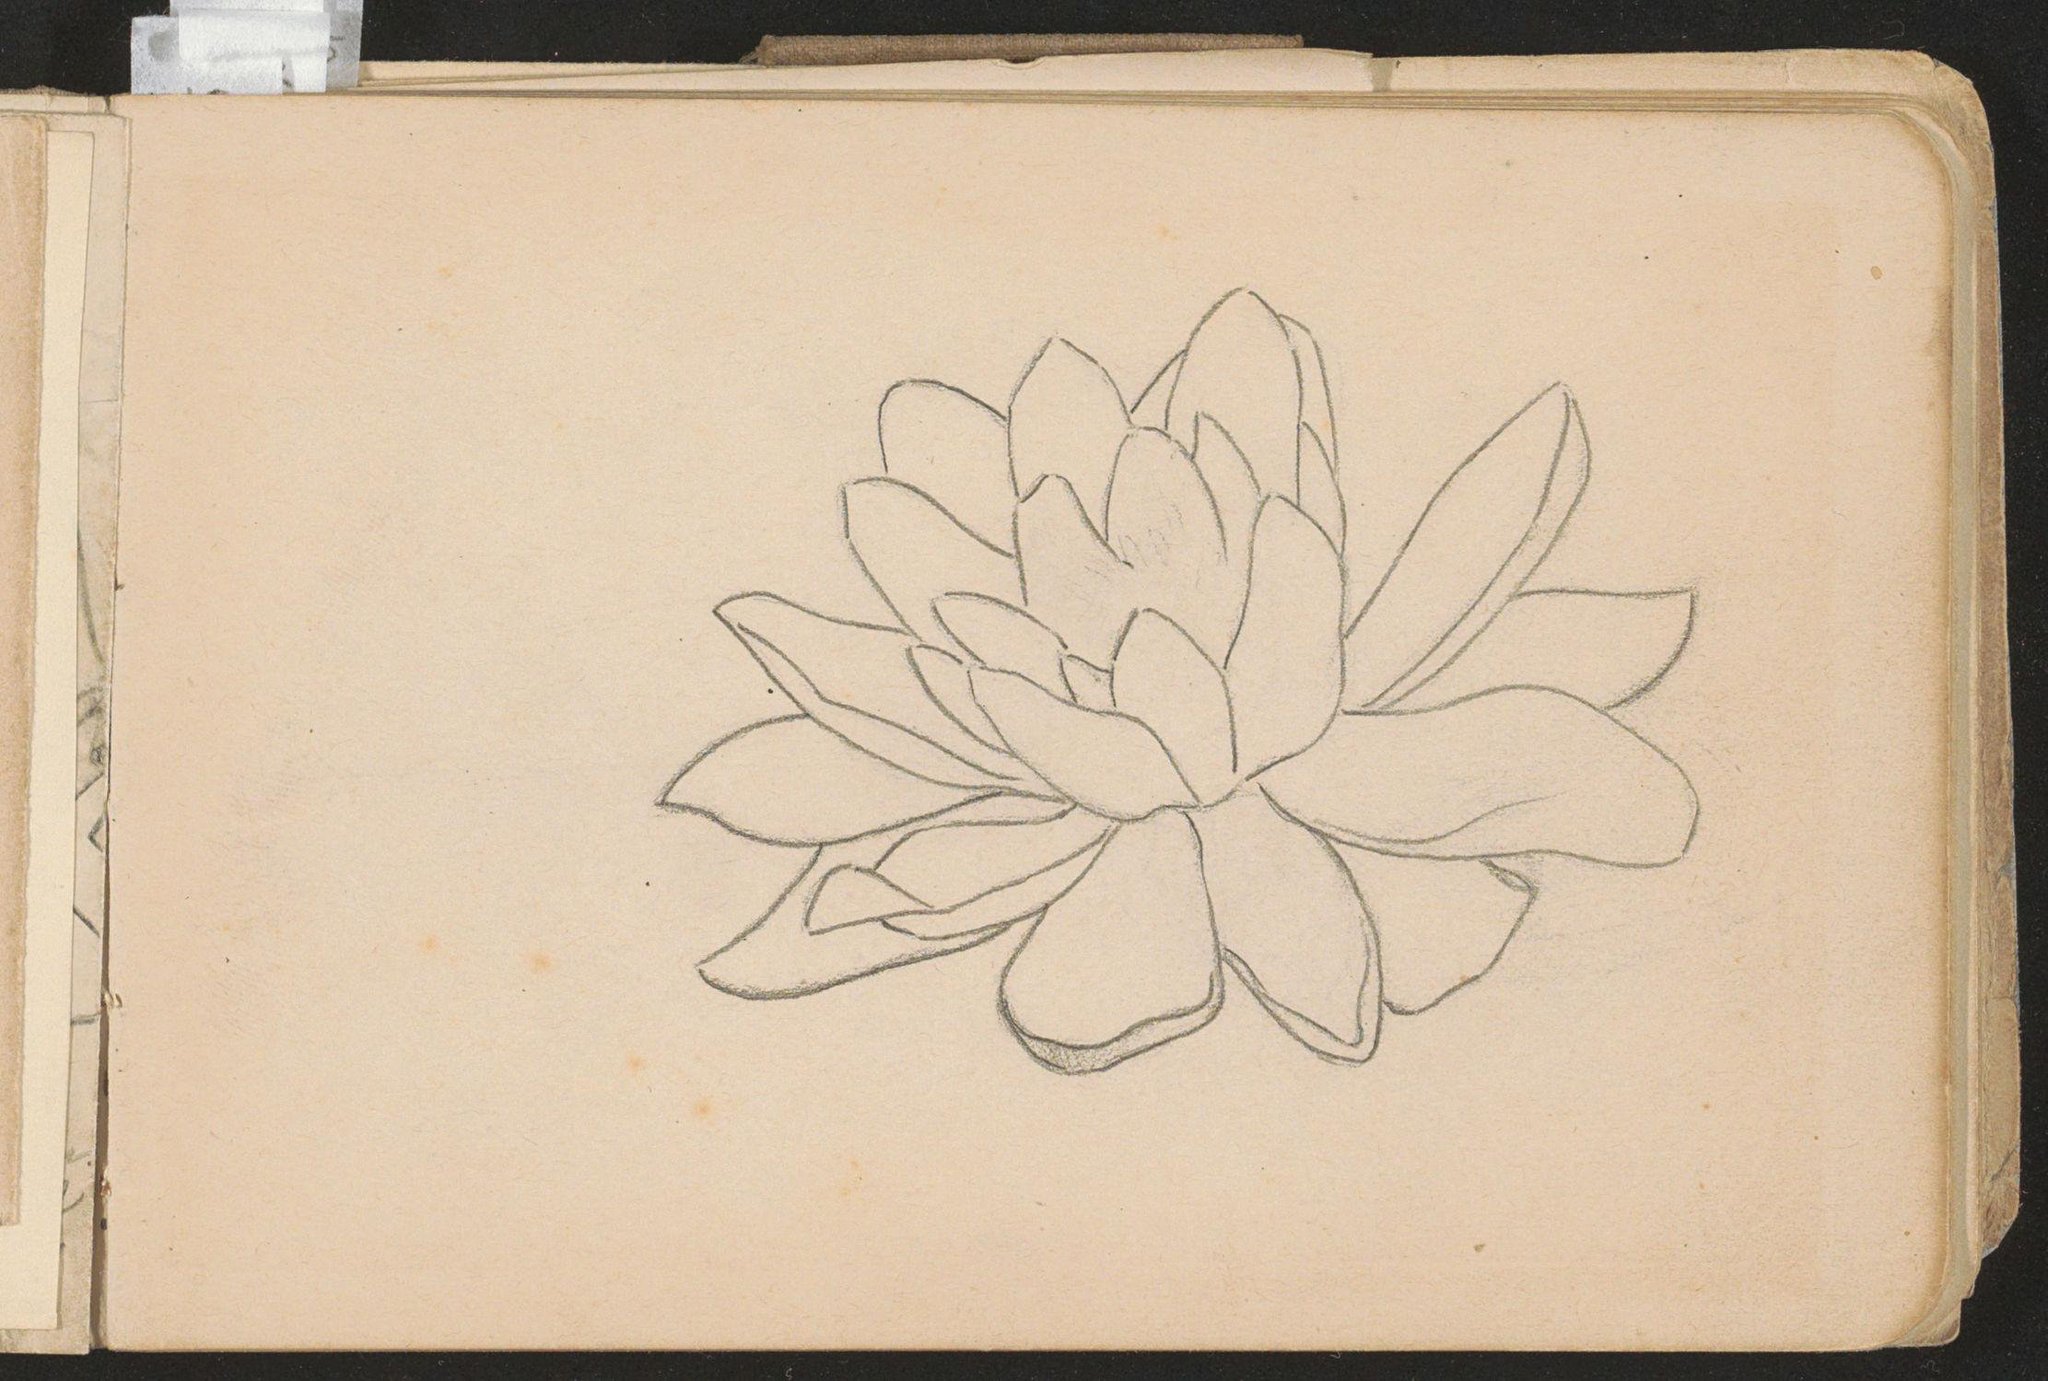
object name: sketchbook leaf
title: Bloem, mogelijk een waterlelie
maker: julie de graag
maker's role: draughtsman, print maker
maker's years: 1877-1924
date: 1894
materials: paper, pencil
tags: flowers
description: Blad 1 recto uit een schetsboek met 35 bladen.